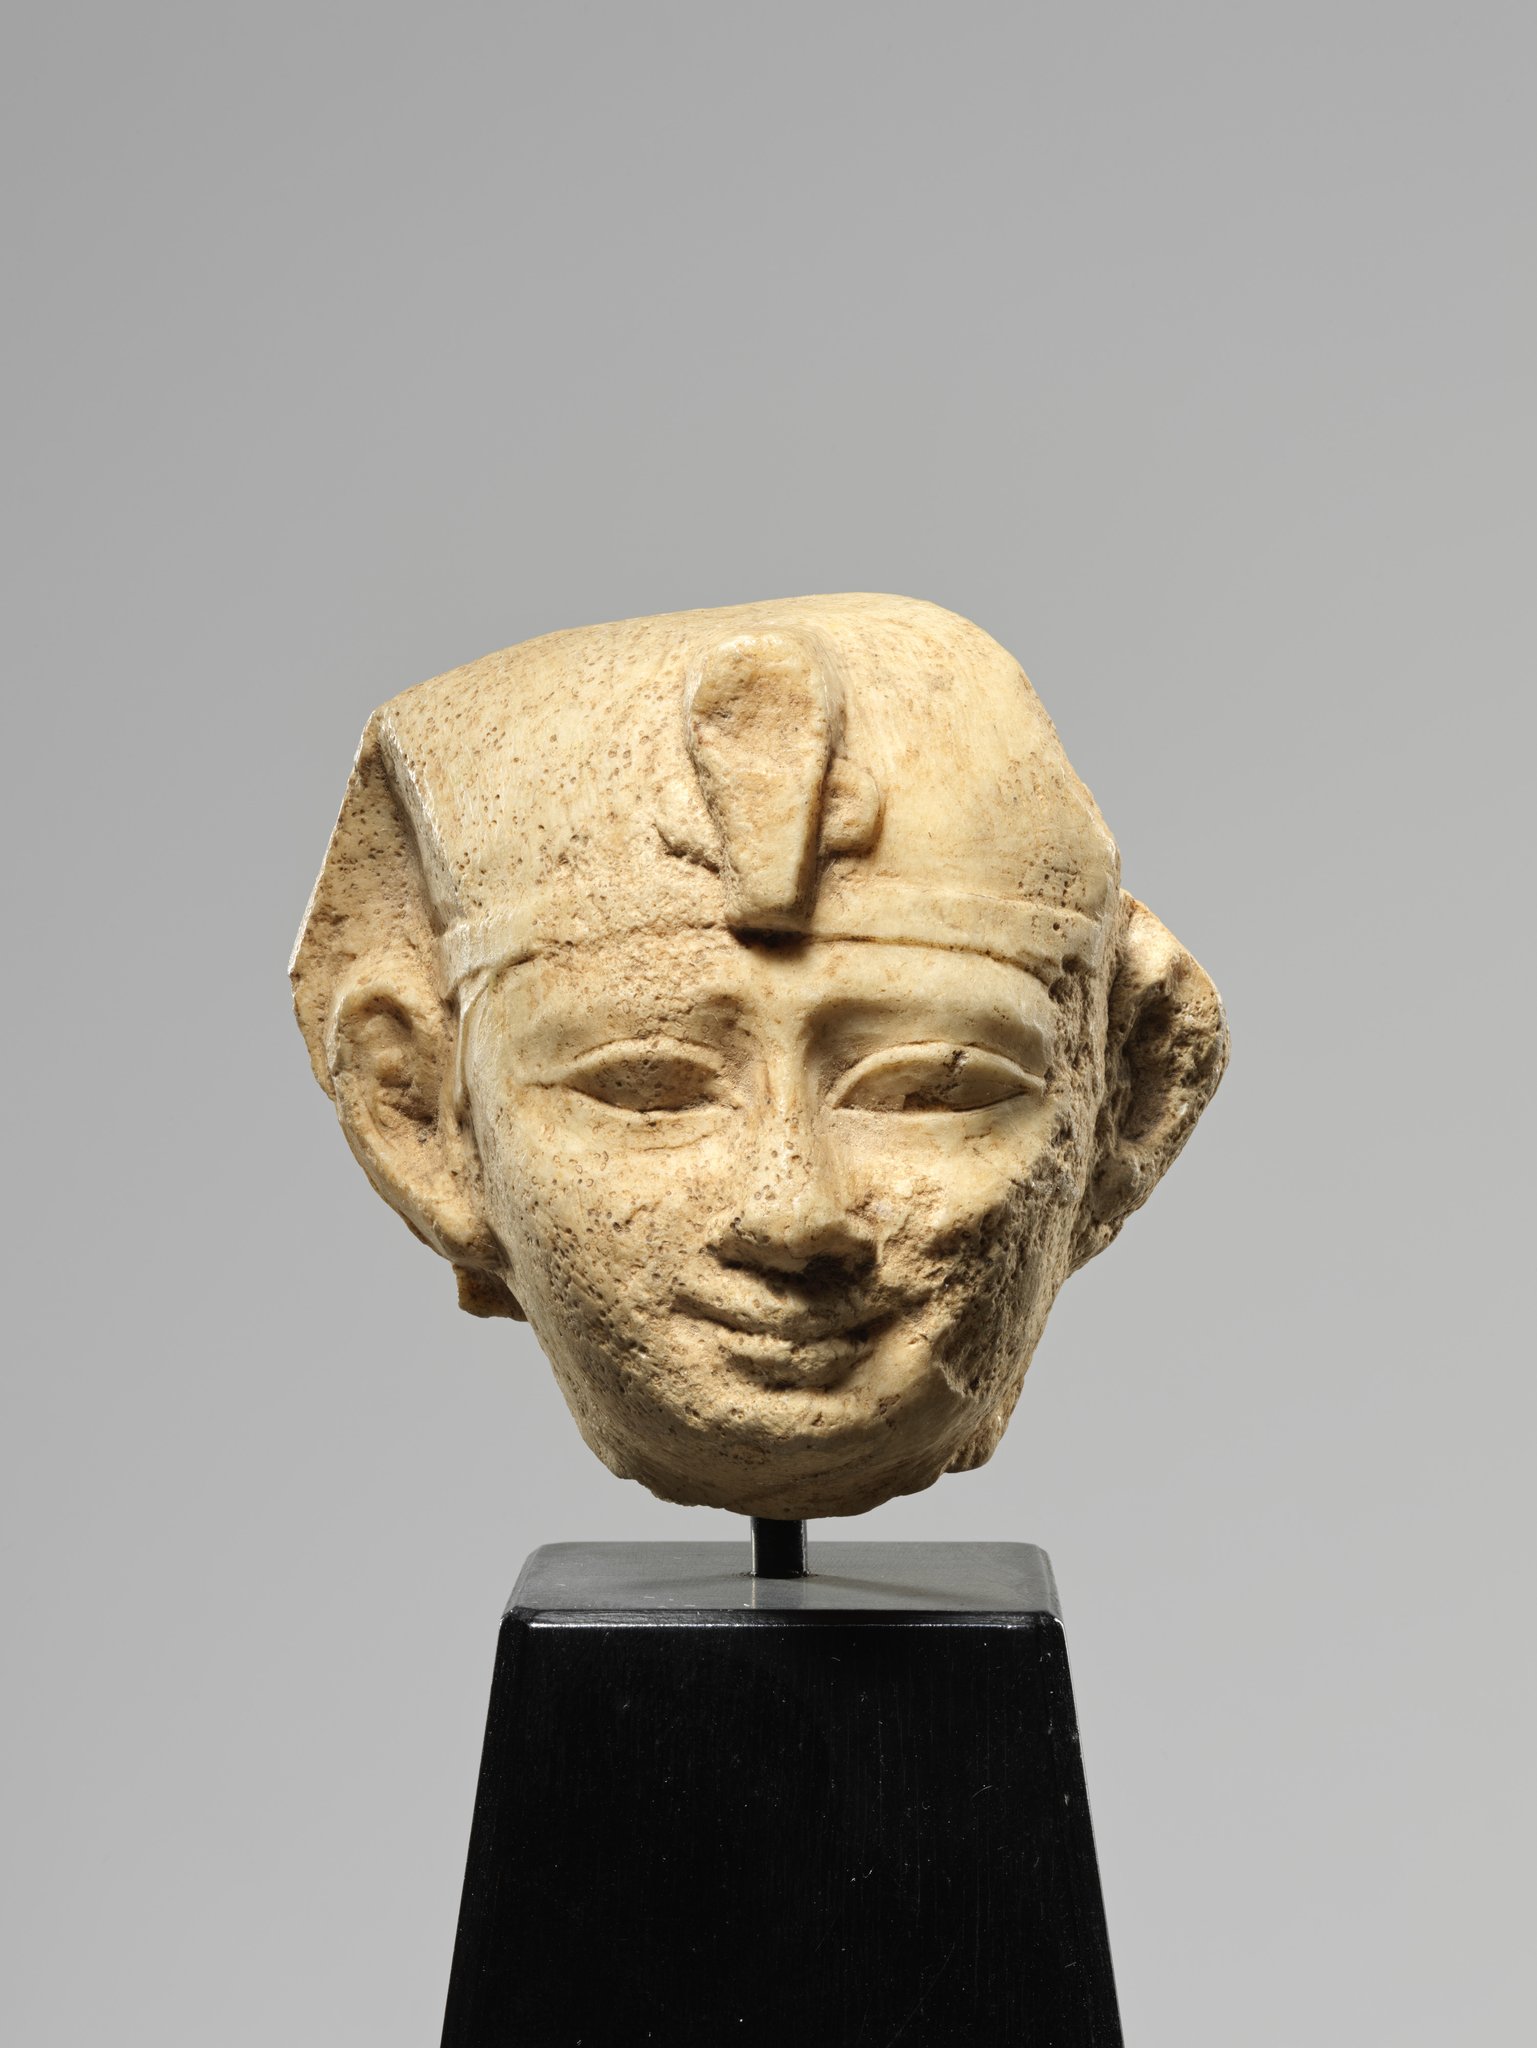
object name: head of a king with a nemes headdress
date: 400-201 BCE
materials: limestone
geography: egypt